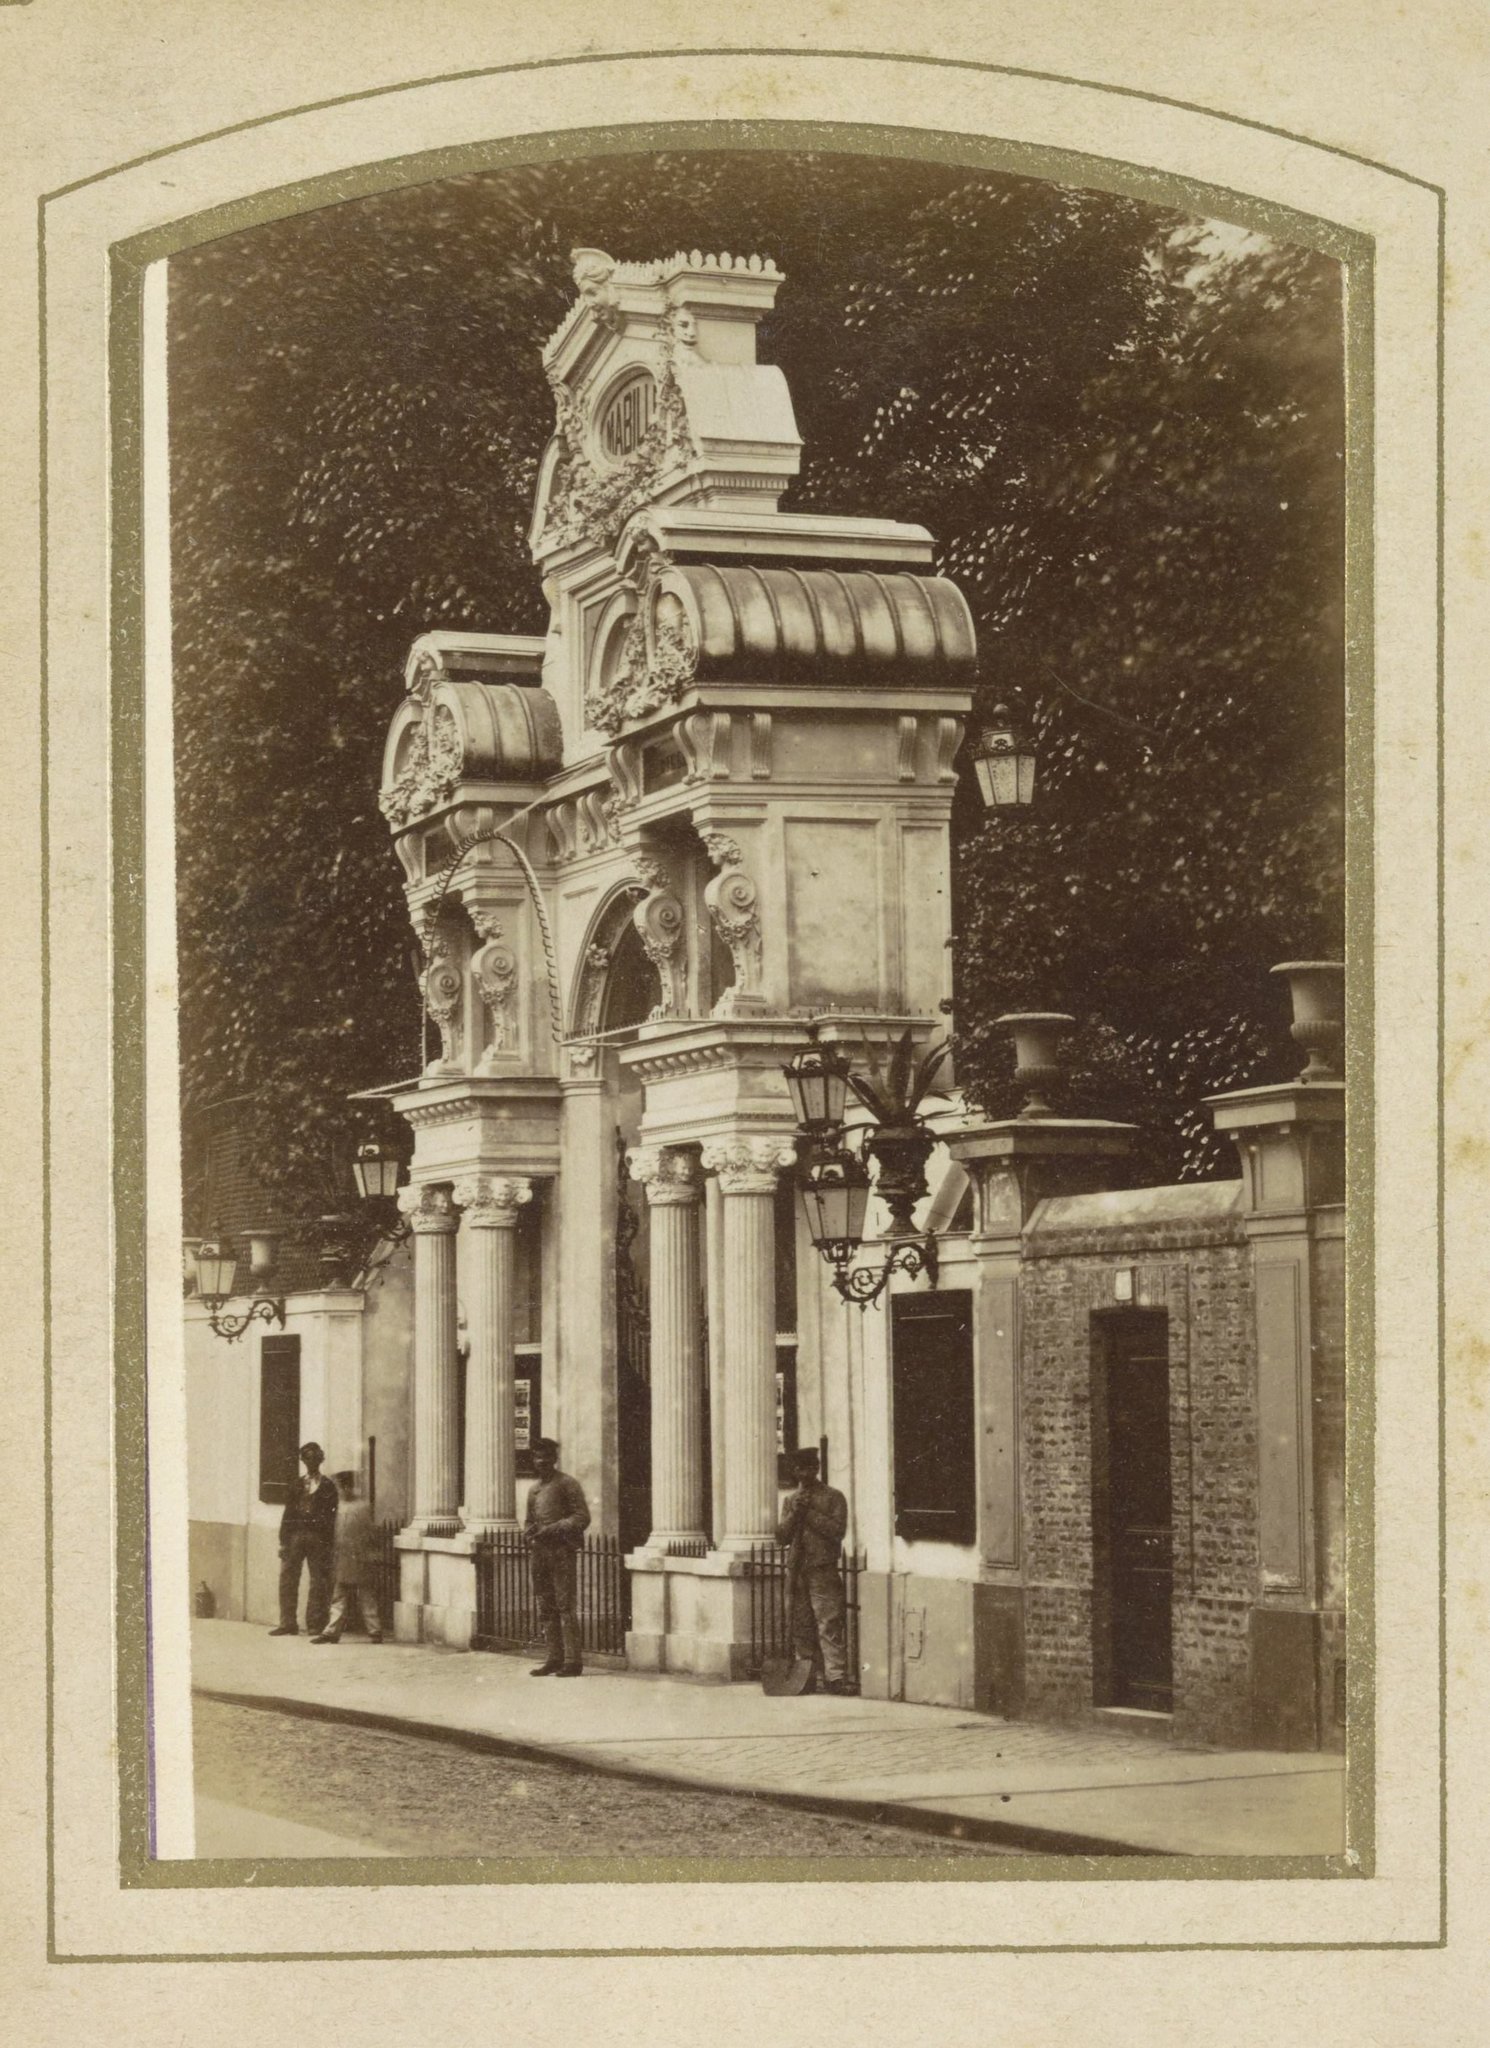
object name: cabinet photograph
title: Ingang van dansgelegenheid Jardin Mabille in Parijs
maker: Anonymous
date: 1870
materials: cardboard, paper, photographic support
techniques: albumen print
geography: paris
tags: night-club, dance-hall (+ variant), gate, entrance, paris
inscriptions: inscription: ‘Bal Mabille’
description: Onderdeel van Fotoalbum met kabinetfoto's van bezienswaardigheden in Parijs.